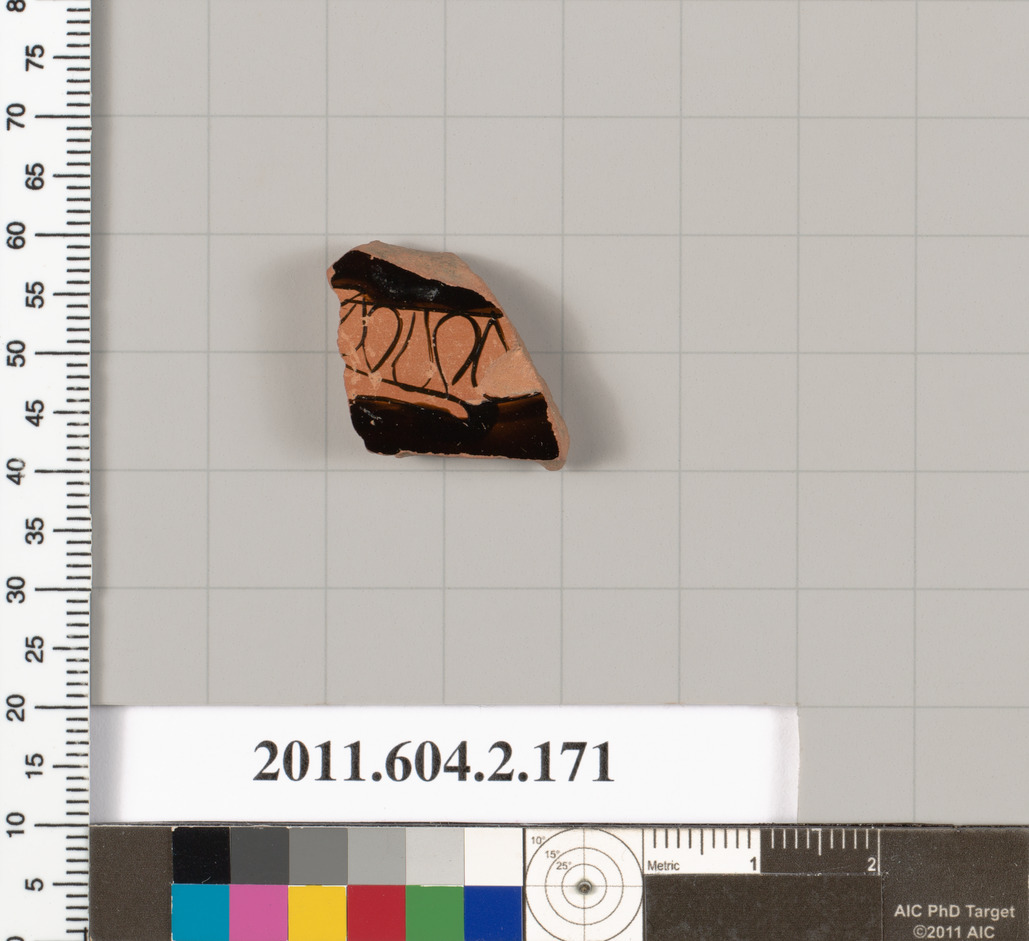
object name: pot fragment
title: Terracotta fragment of a pot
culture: greek, attic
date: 470-460 BCE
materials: terracotta